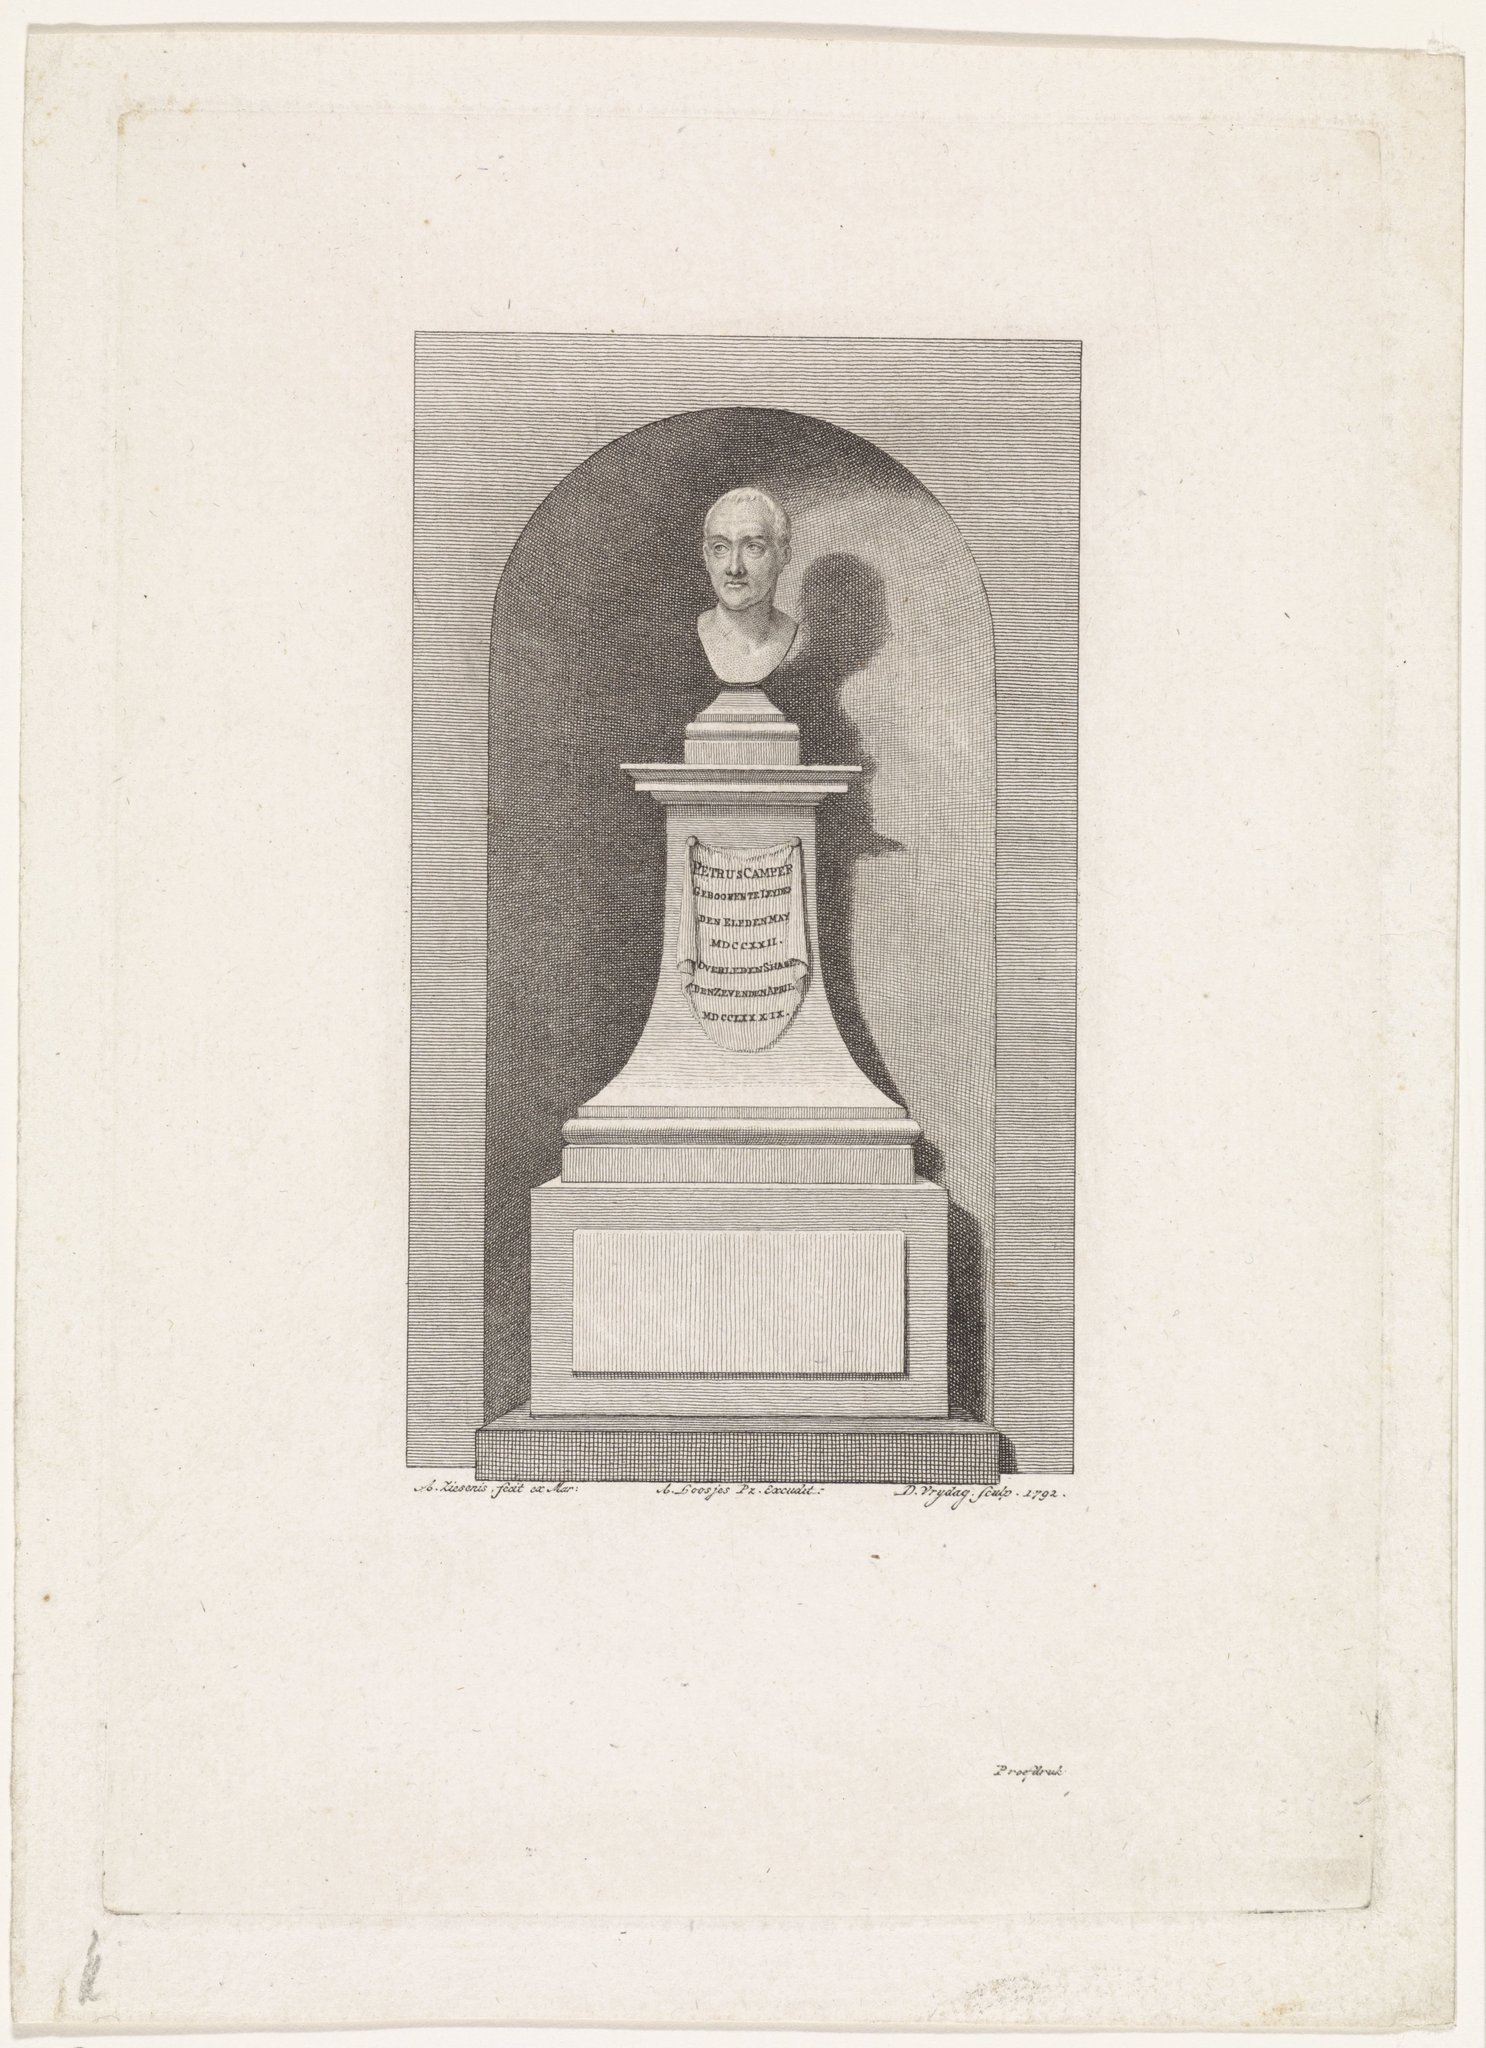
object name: print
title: Monument voor Petrus Camper in de St. Pieters Kerk te Leijden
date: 1792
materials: paper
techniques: engraving, etching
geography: amsterdam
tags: leiden, the hague, print maker, draughtsman, petrus camper, grave, tomb and other grave-forms and grave-markers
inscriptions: collector's mark: Lugt 2228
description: Nis met buste van Petrus Camper. Grafmonument in de Pieterskerk in Leiden.